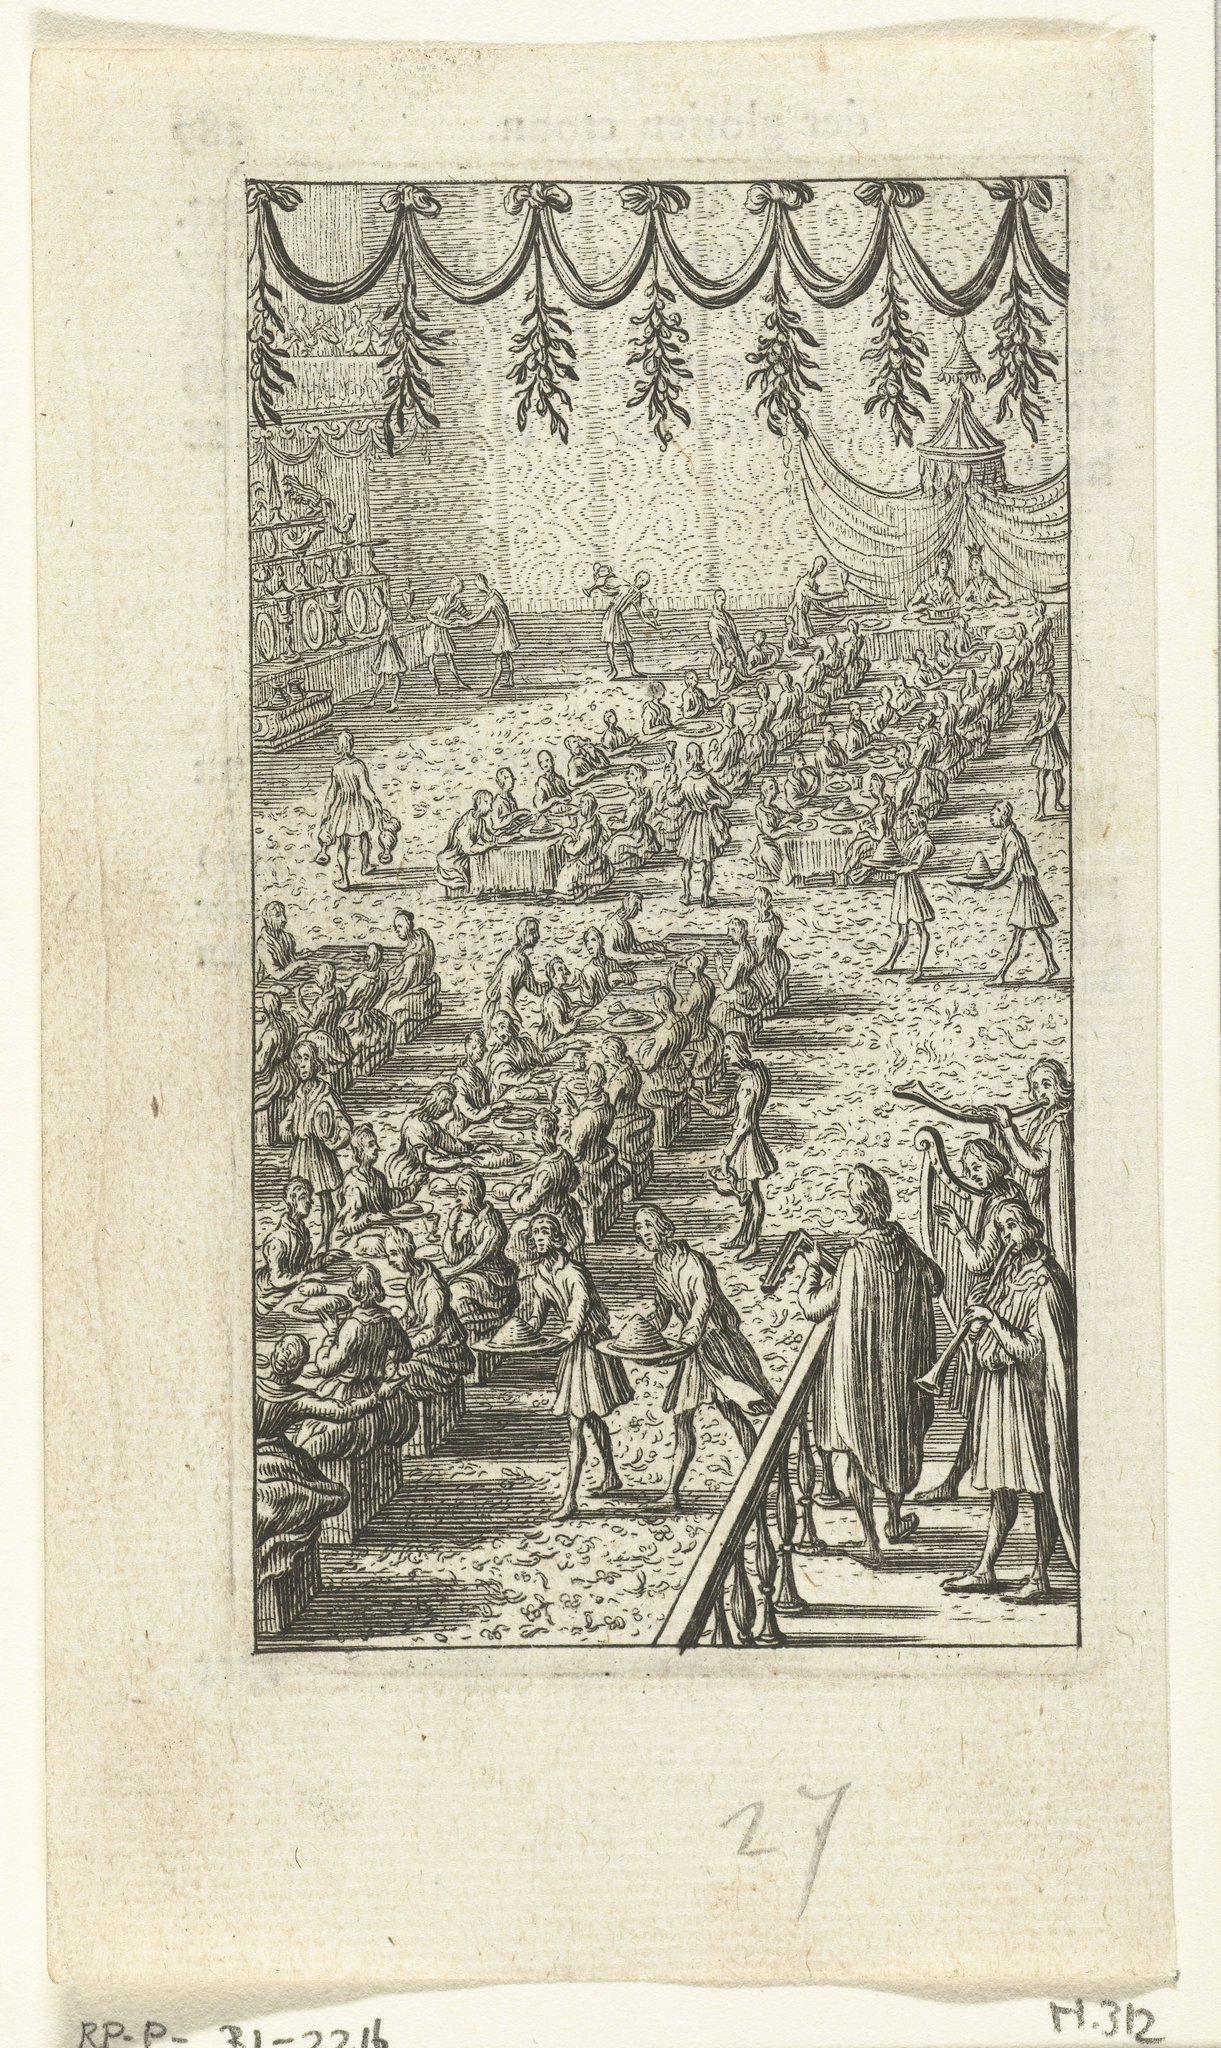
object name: print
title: Duyfkens en Willemynkens pelgrimagie tot haren beminden binnen Iervsalem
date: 1590-1627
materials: paper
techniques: engraving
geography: antwerp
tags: wedding feast, wedding meal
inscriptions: collector's mark: Lugt 2228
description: Prent uit: Boëtius Adamsz. Bolswert, Duyfkens en Willemynkens pelgrimagie tot haren beminden binnen Iervsalem. Haerlieder teghenspoet, belet en eynde, Antwerpen, Hendrick Aertssens, 1638. Op het verso staat een verklarende Nederlandse tekst bij de voorgaande illustratie in dit devotie boekje (vergelijk RP-P-BI-2215).